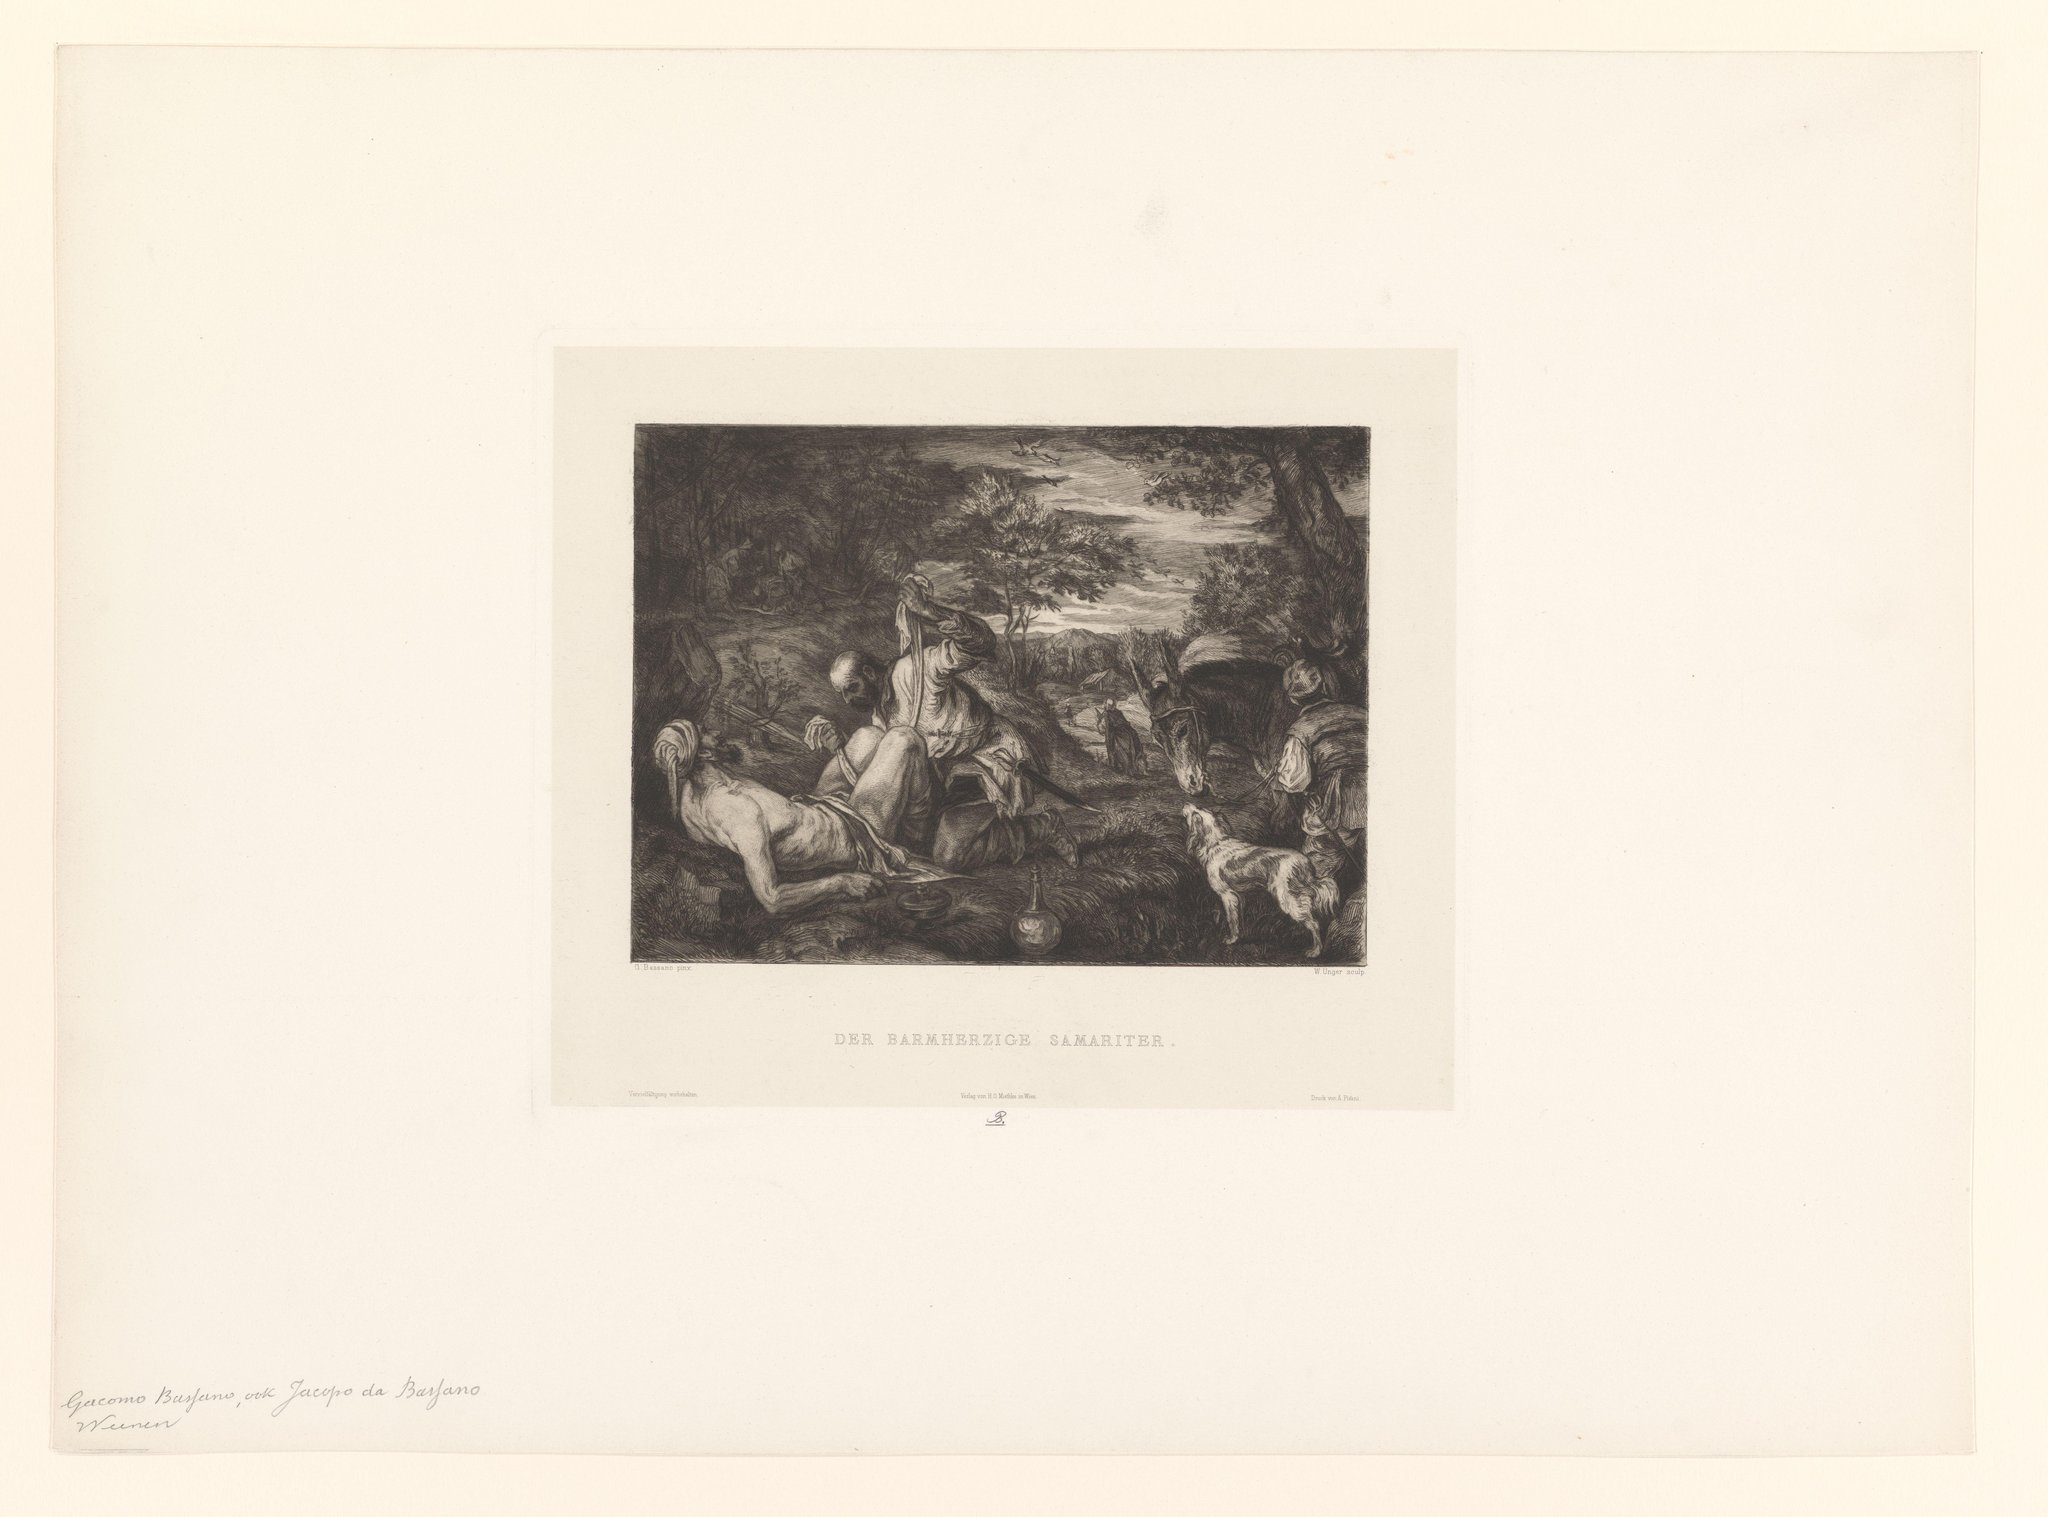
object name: print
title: Barmhartige Samaritaan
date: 1861-1889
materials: paper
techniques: etching, intaglio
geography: vienna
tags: the good samaritan (luke 10:30-37)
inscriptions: collector's mark: Lugt 2228